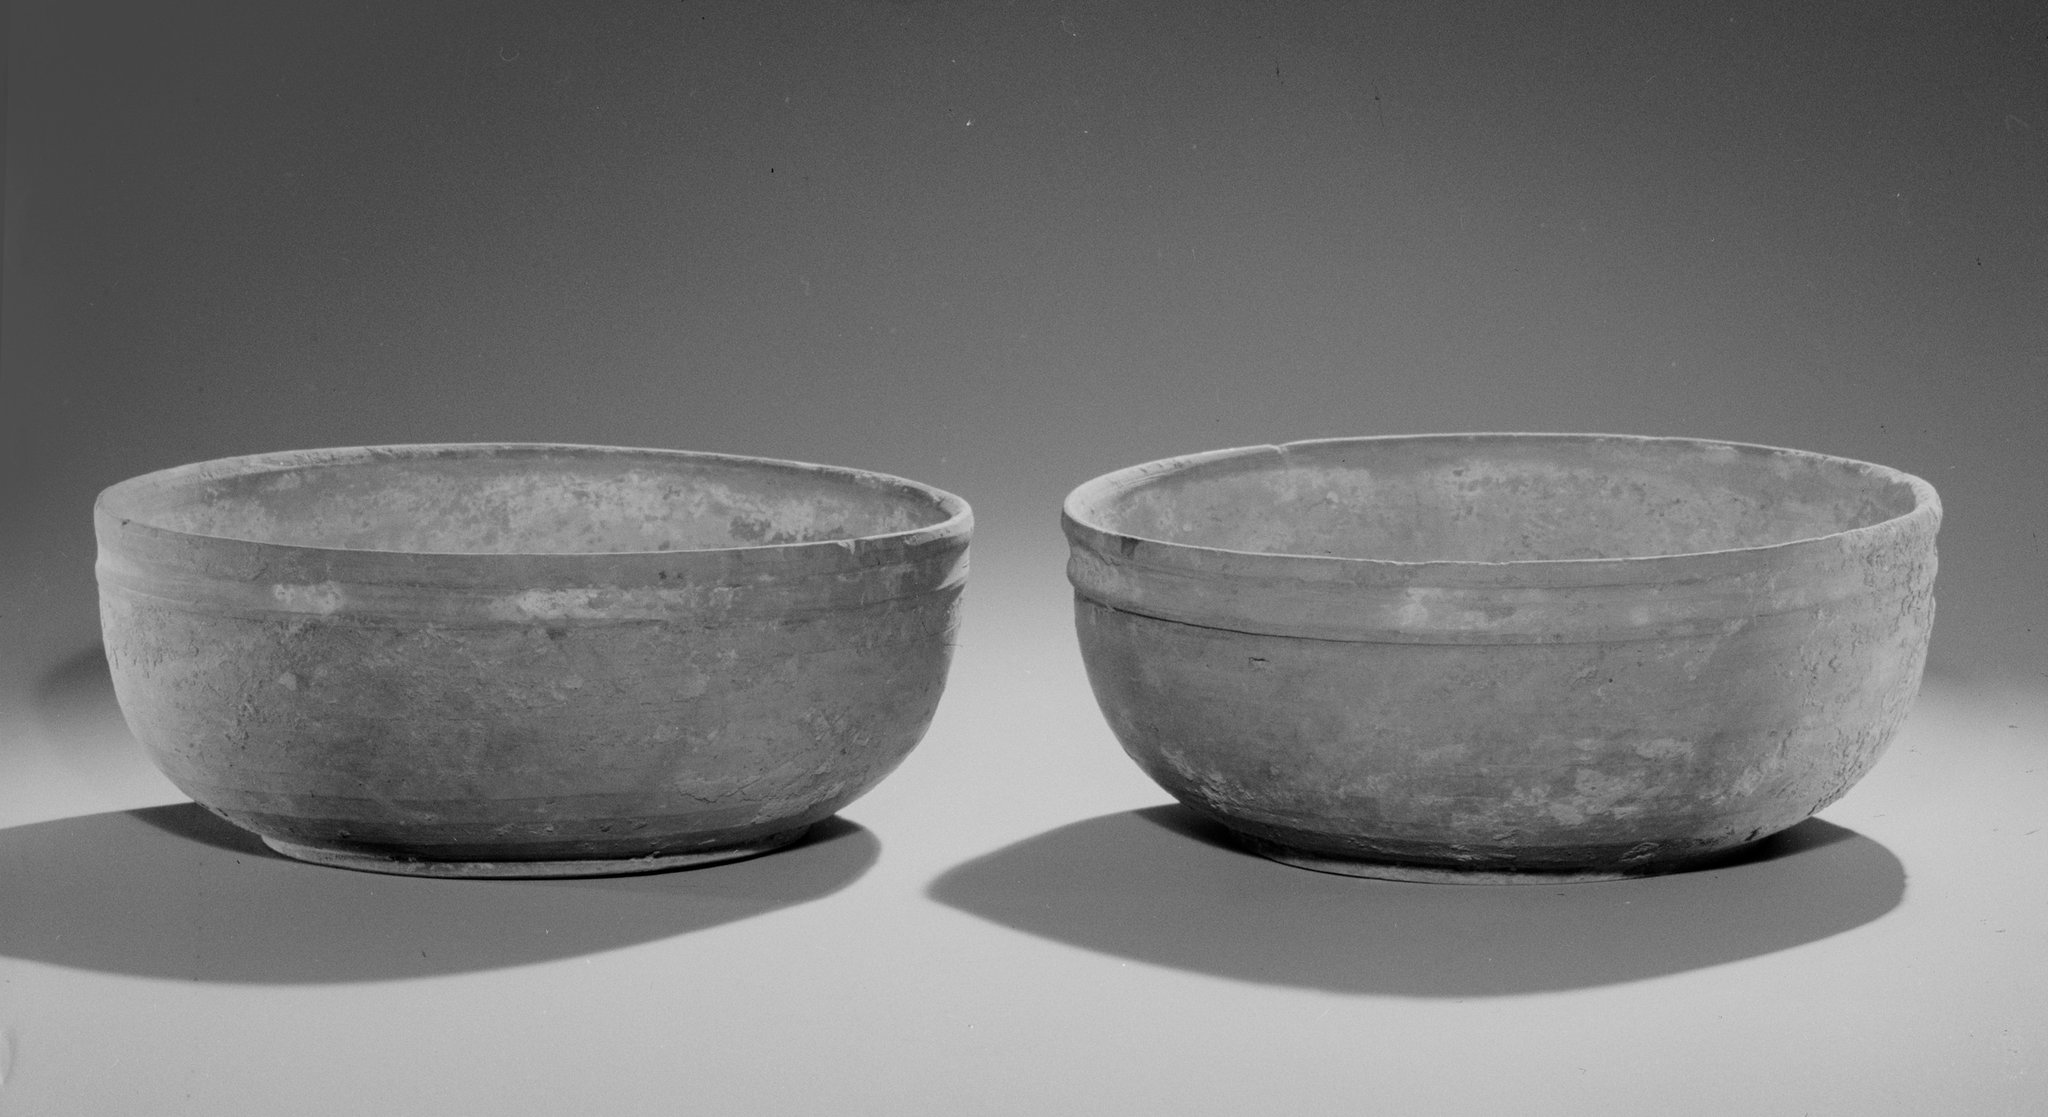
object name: bowl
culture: chinese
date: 618-907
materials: earthenware